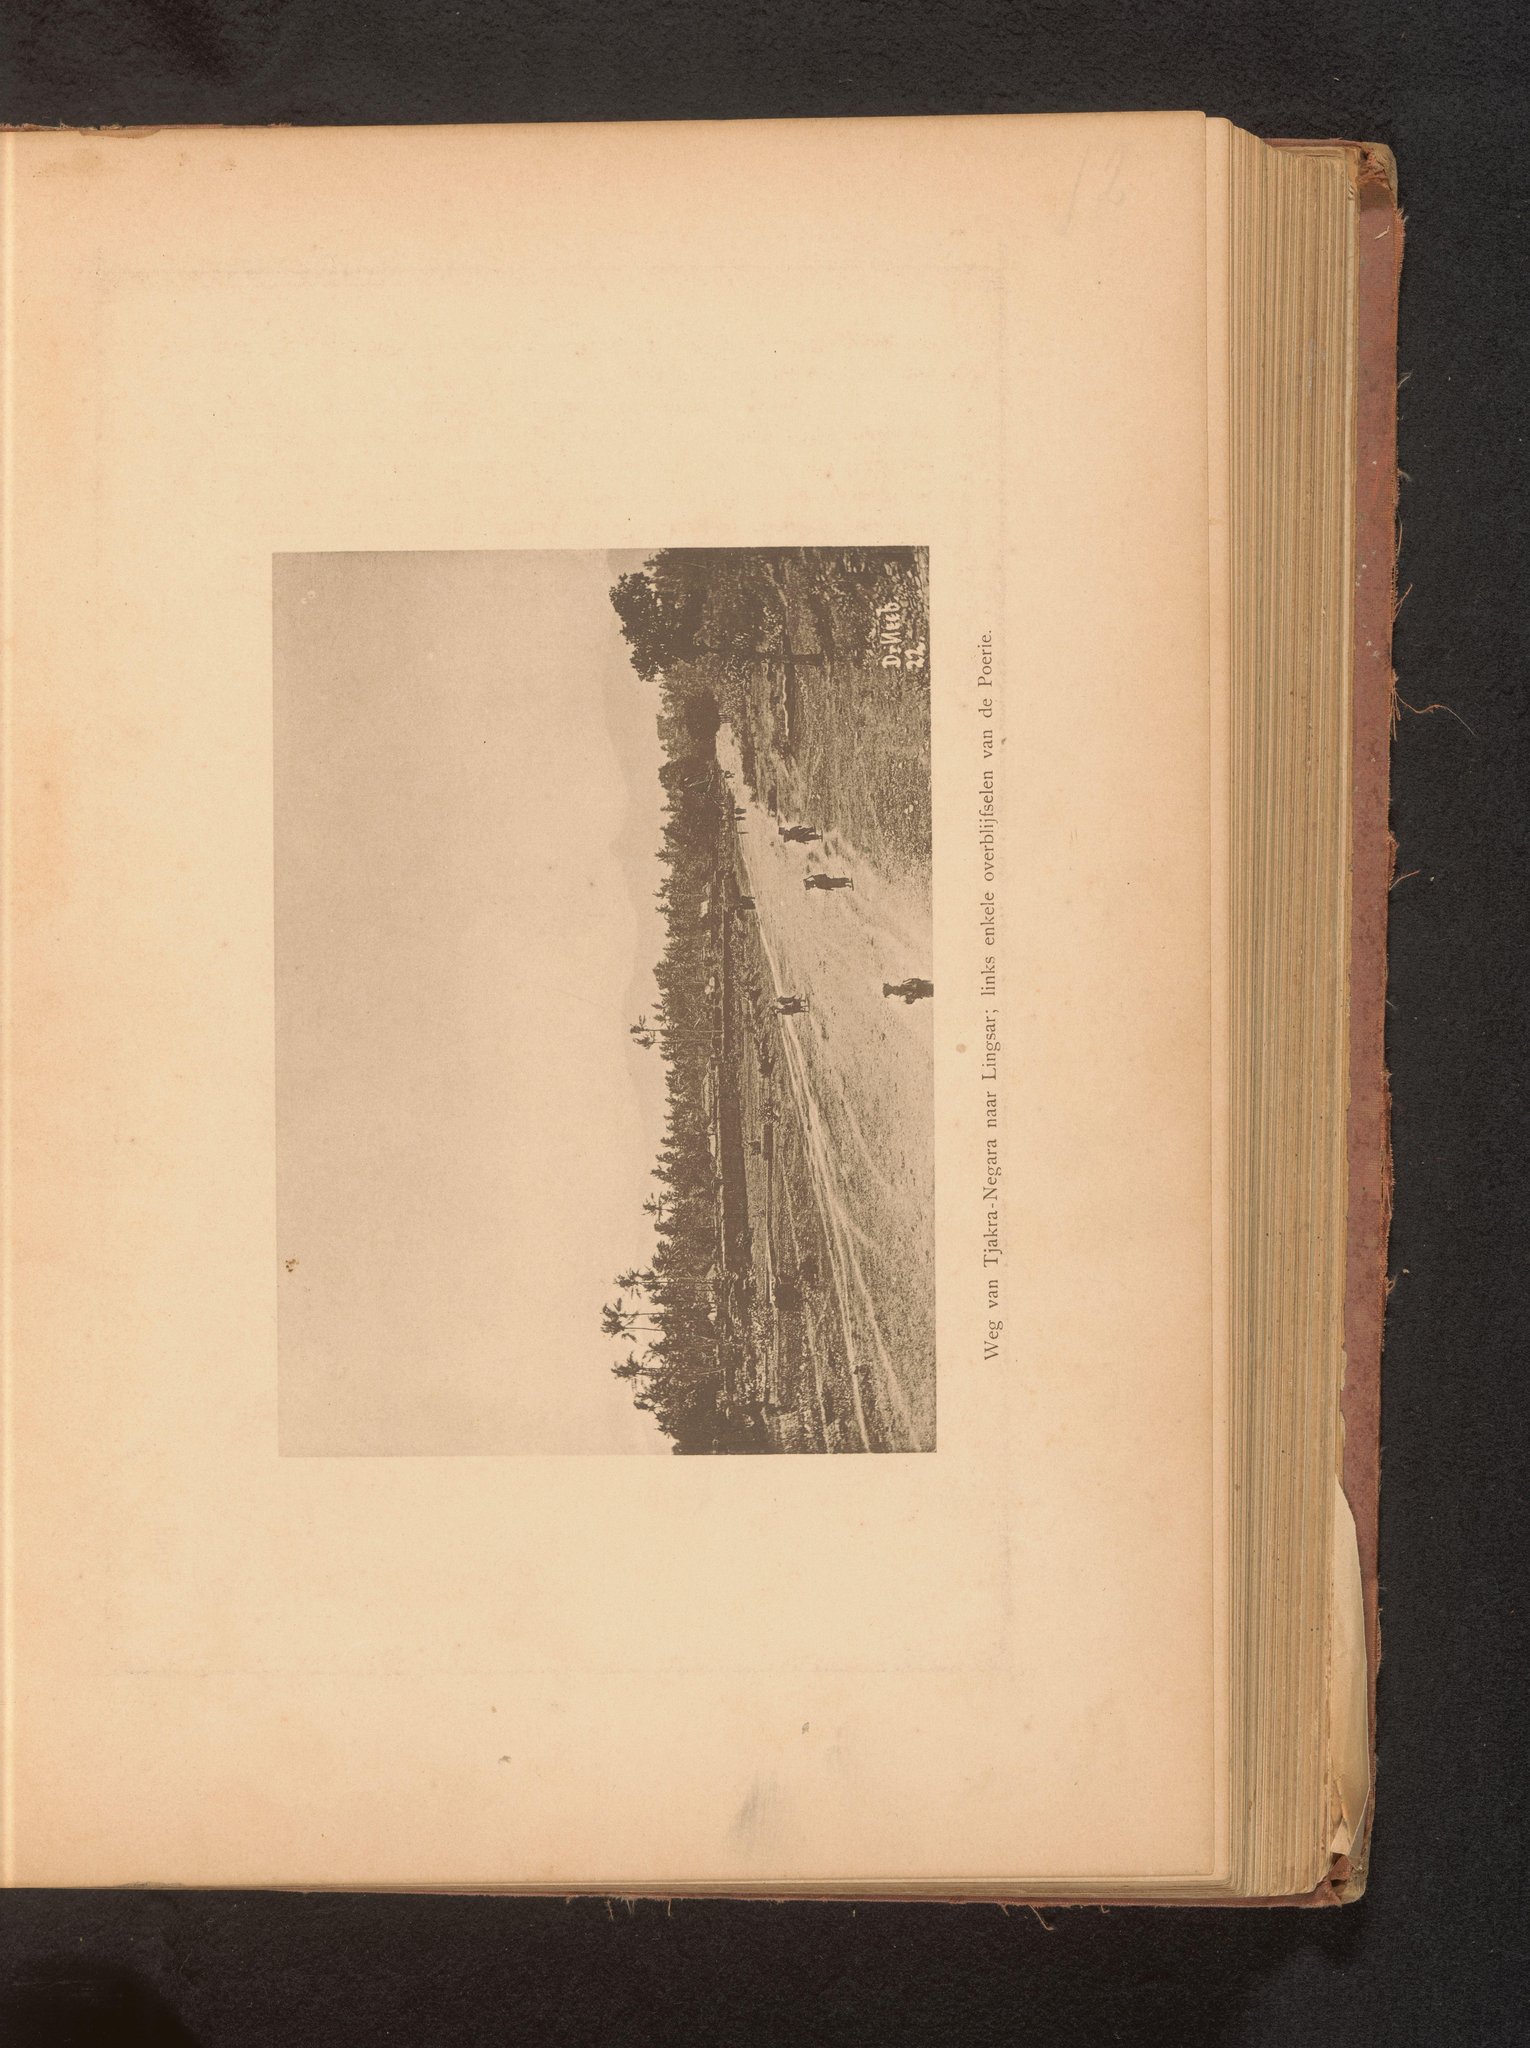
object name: photomechanical print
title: Gezicht op Sociëteit Lombokclub te Ampenan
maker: christiaan johan neeb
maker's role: arts, fotograaf, officier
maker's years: 1860-1925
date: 1892-1897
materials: paper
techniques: photograph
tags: landscape with ruins, road, path, indonesia